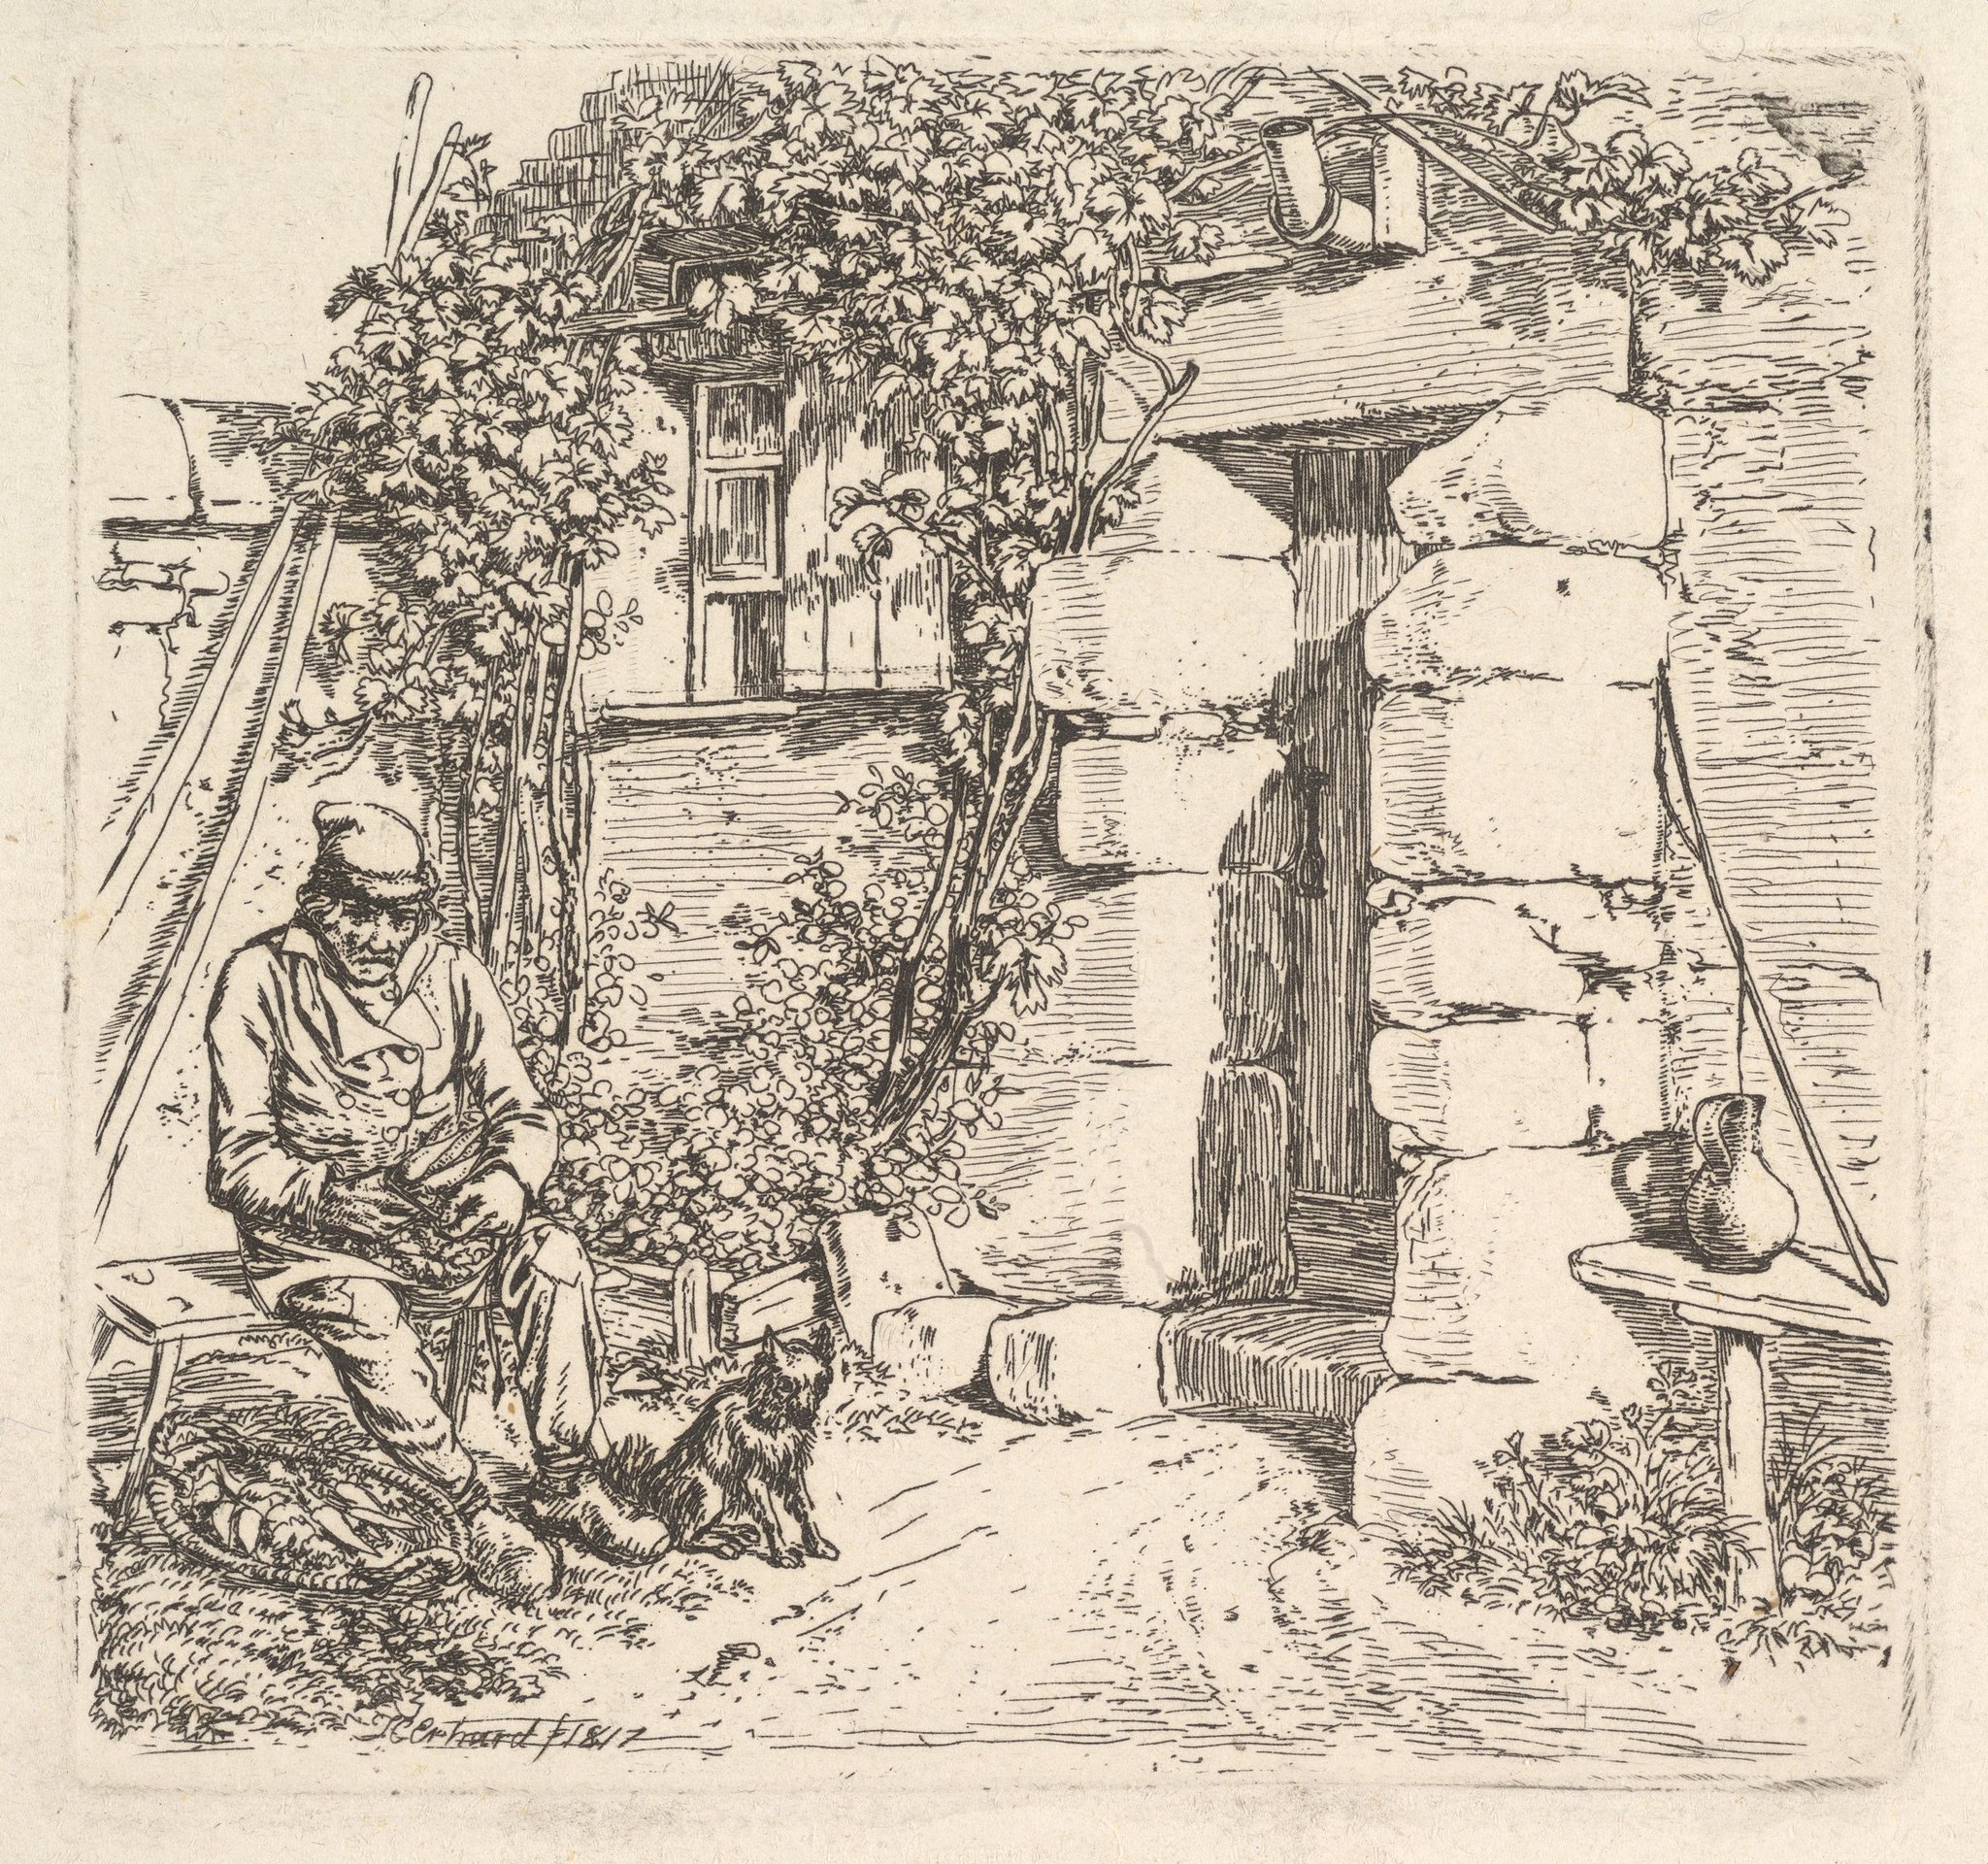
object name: print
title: The Old Man and his Pomeranian Dog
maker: johann christoph erhard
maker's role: artist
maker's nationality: german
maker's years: 1795-1822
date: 1817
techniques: etching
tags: doors,men,dogs,plants